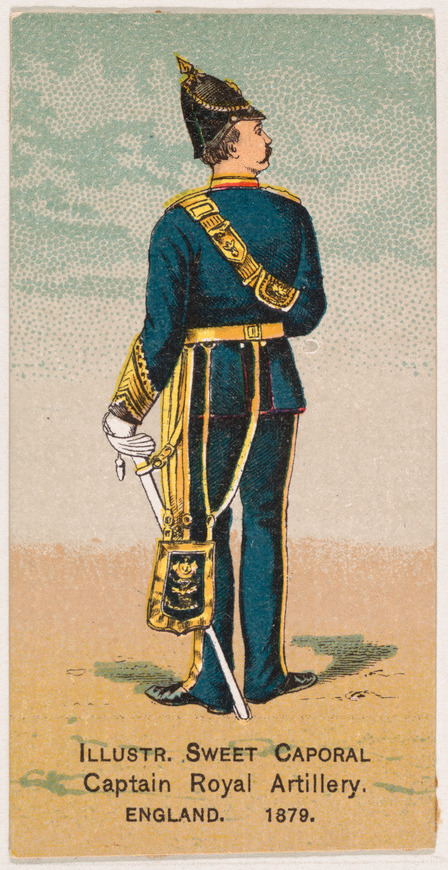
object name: print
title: Captain, Royal Artillery, England, 1879, from the Military Series (N224) issued by Kinney Tobacco Company to promote Sweet Caporal Cigarettes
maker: kinney brothers tobacco company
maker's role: publisher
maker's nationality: american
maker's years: 1869-2011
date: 1888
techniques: color lithograph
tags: military,men,profiles